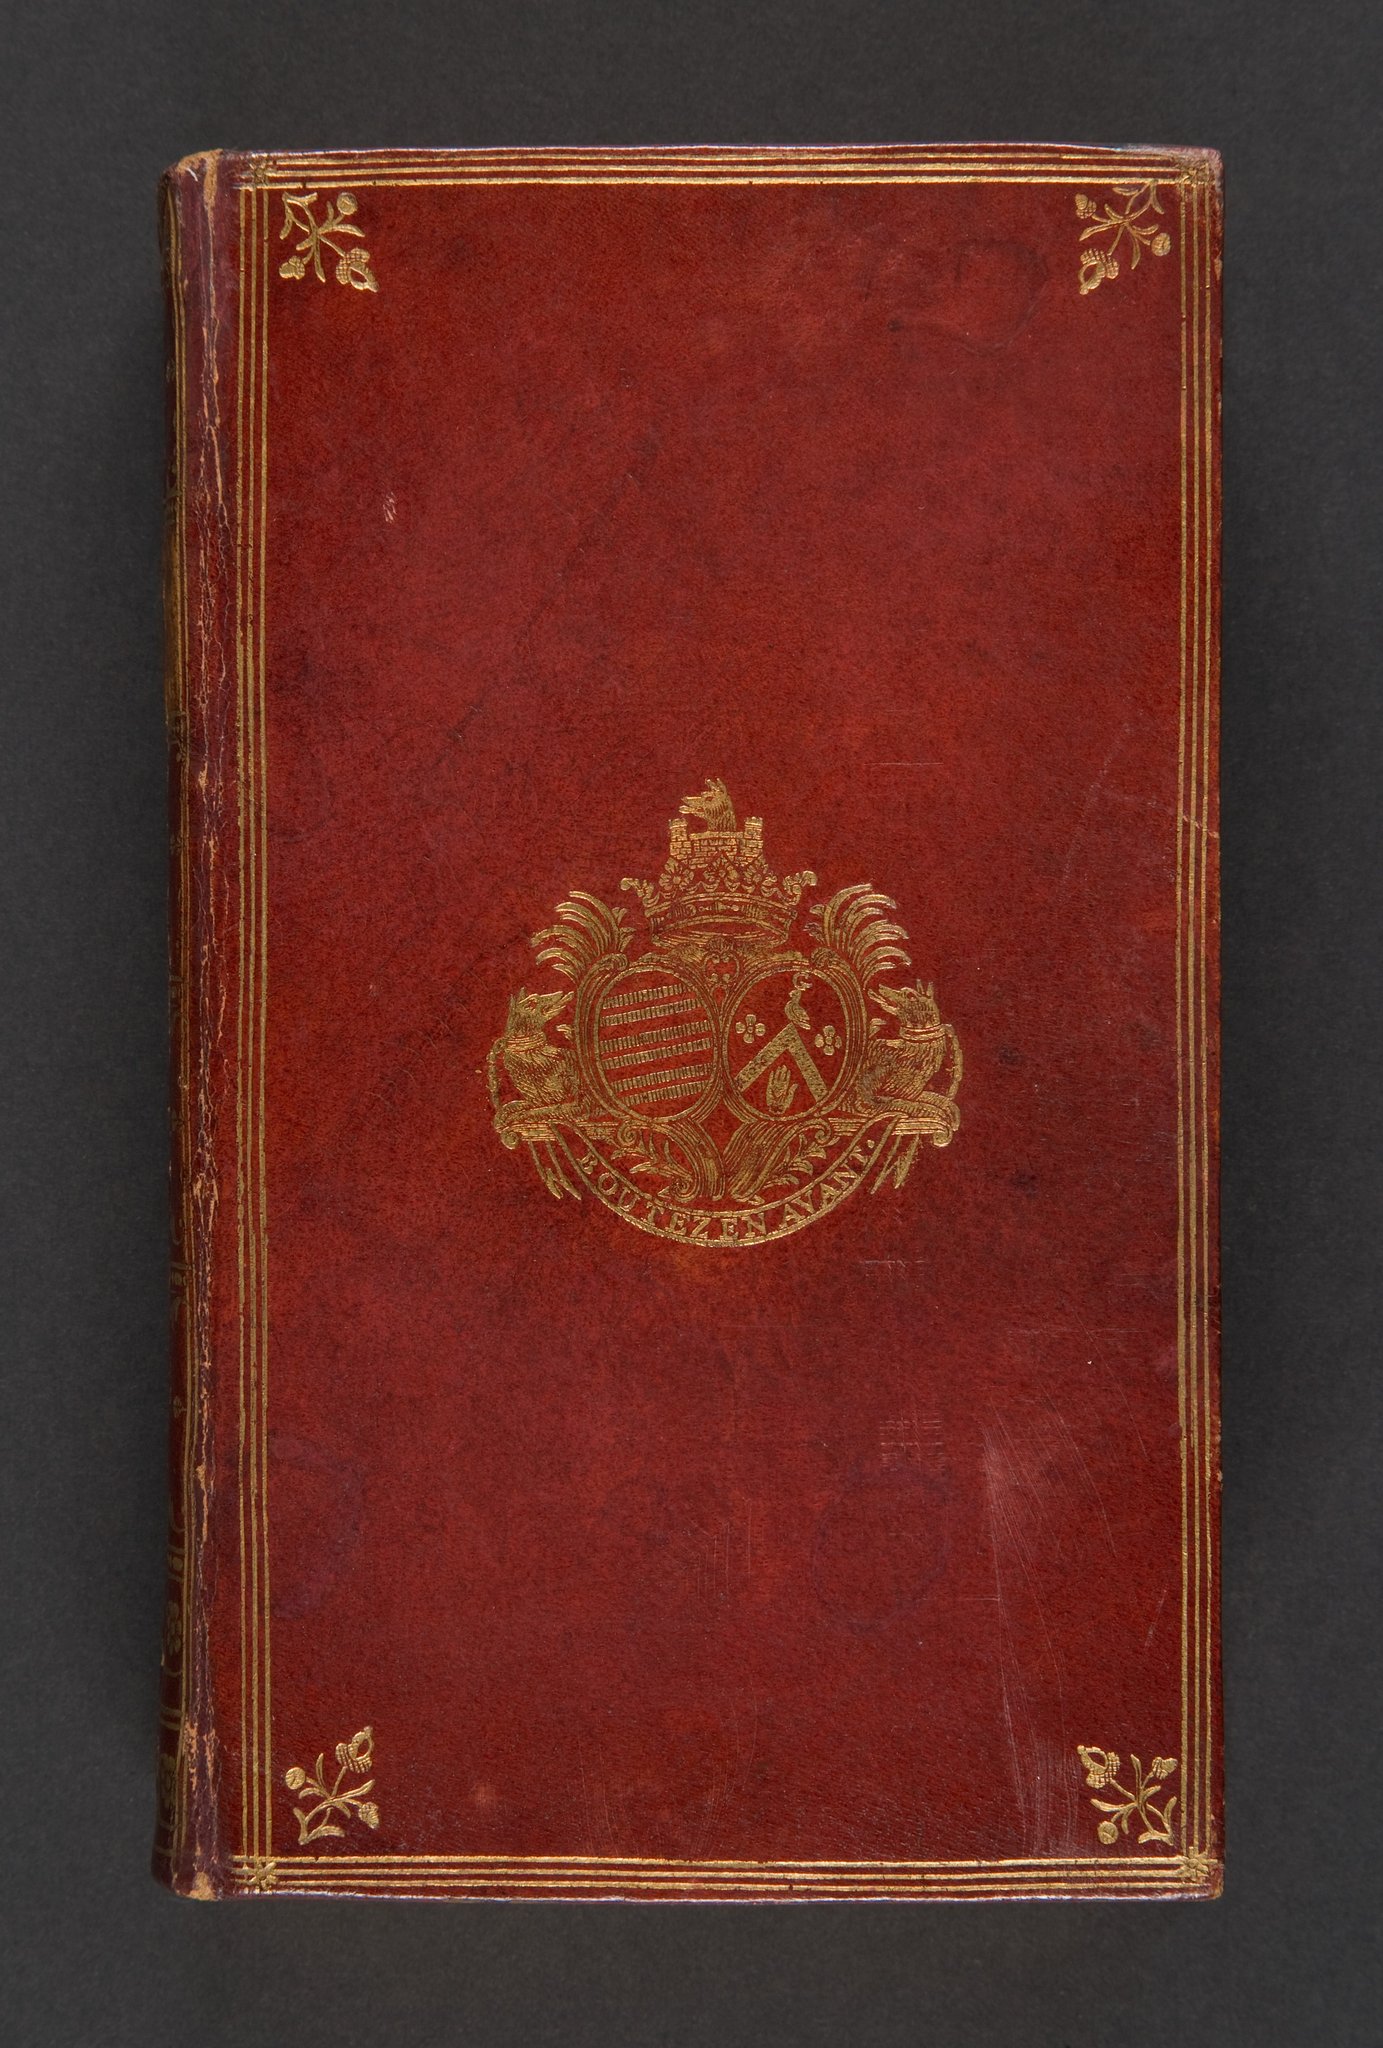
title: Memoires de Montecuculi, generalissime des troupes de l'empereur : divisés en trois livres : I. De l'art militaire en général, II. De la guerre contre le turc, III. Relation de la campagne de 1664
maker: prince raimondo montecuccoli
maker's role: author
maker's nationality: italian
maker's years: 1609-1680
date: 1760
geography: france